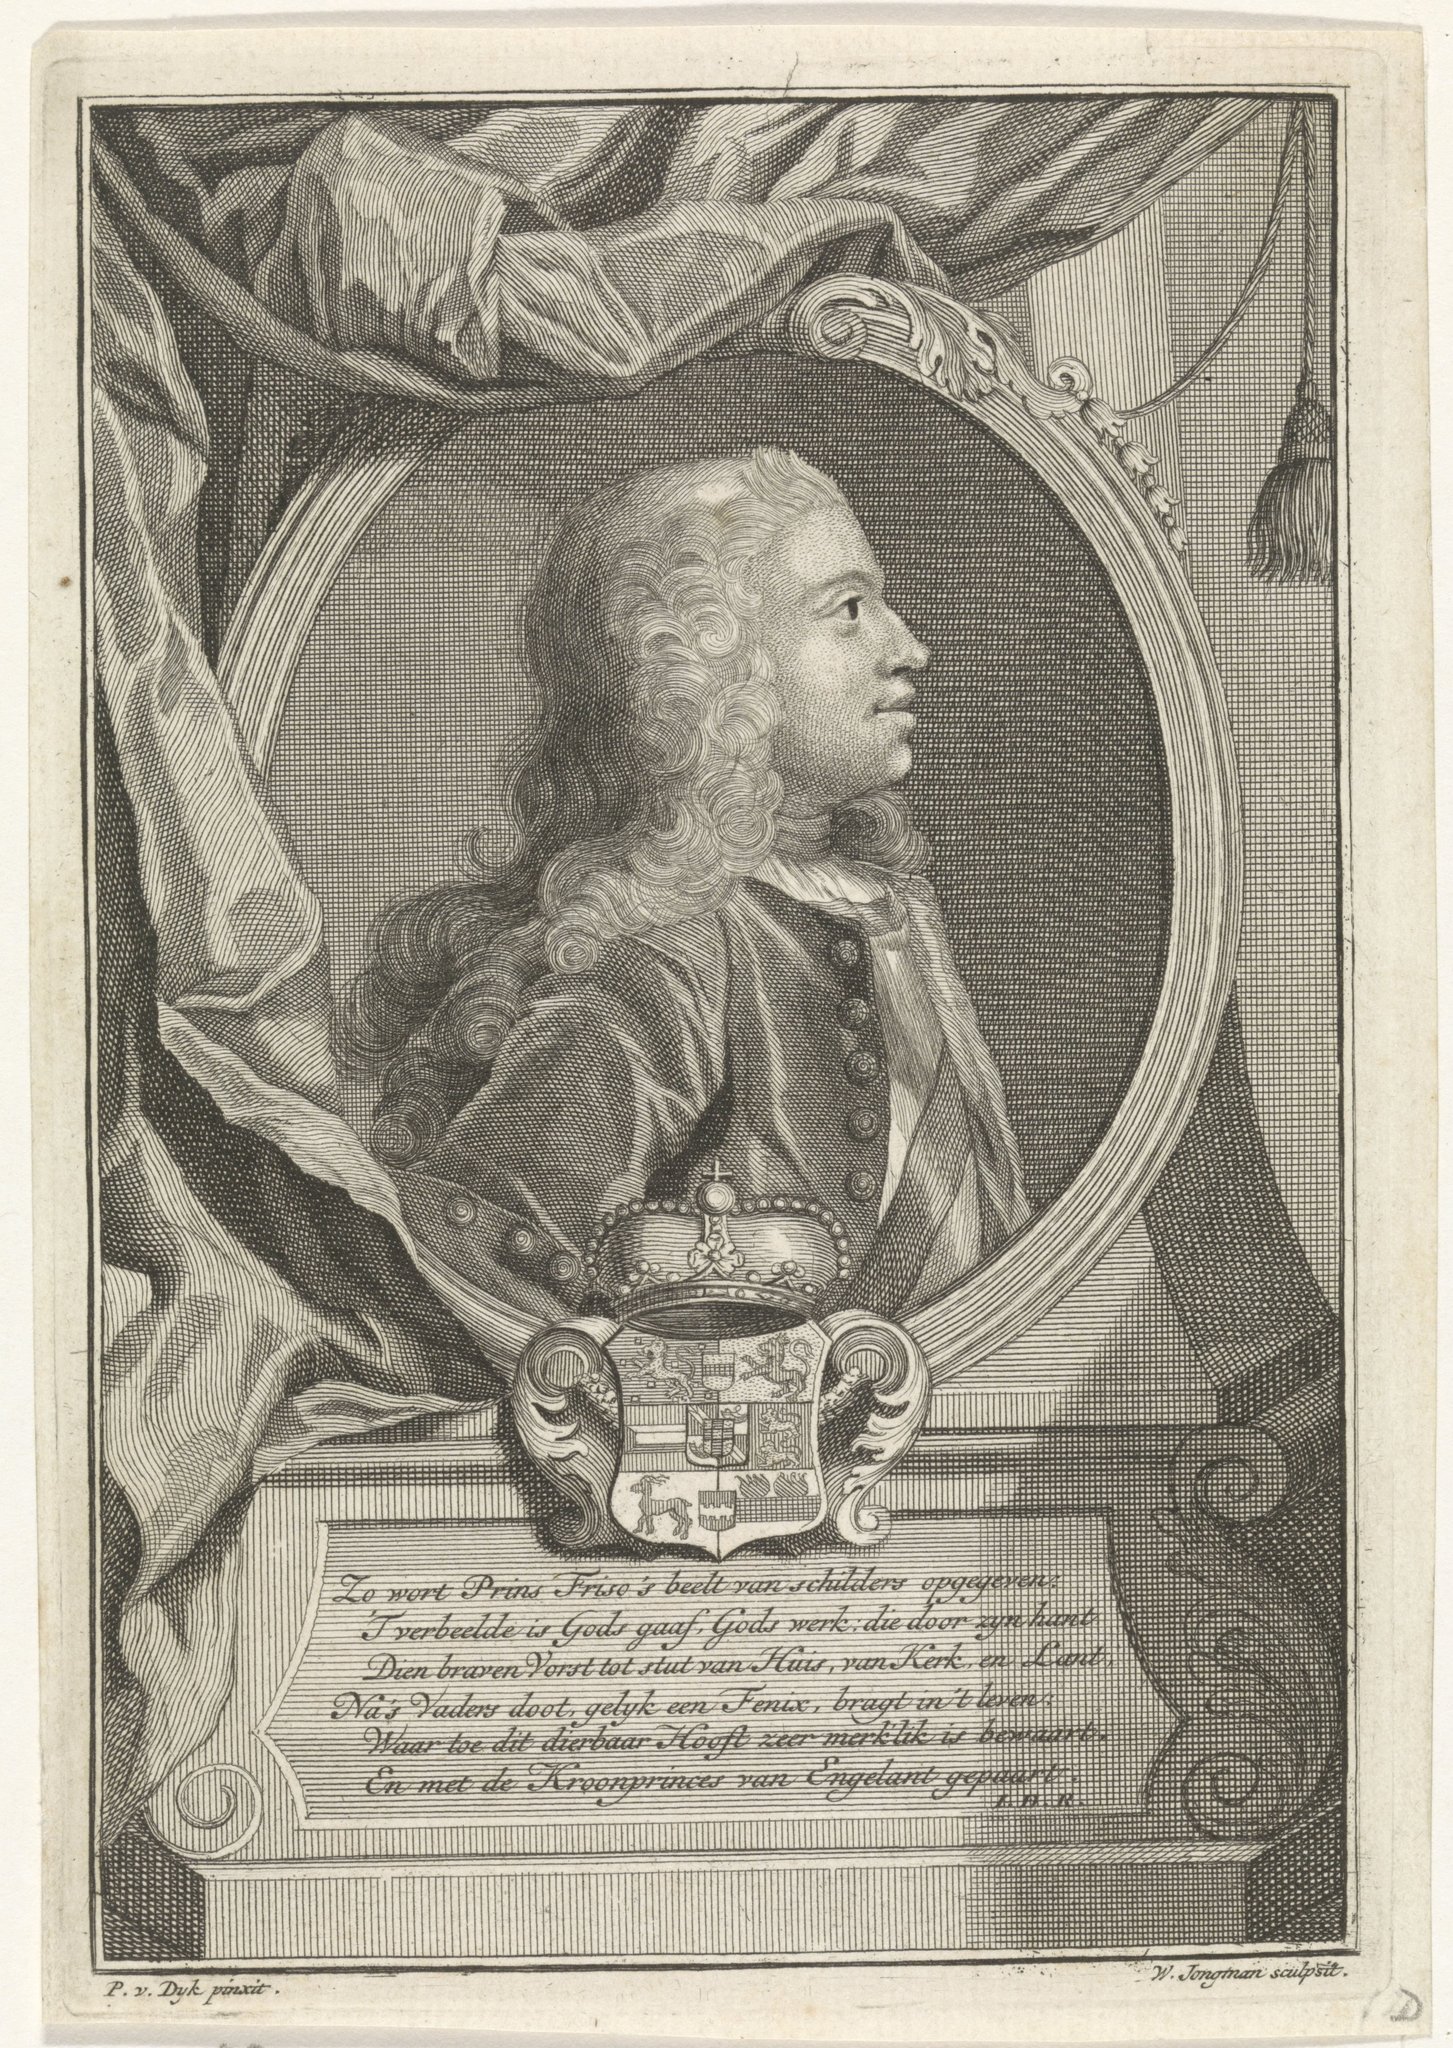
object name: print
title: Portret van Willem IV, prins van Oranje-Nassau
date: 1712-1744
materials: paper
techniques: engraving, etching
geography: amsterdam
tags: the hague, willem iv (prins van oranje-nassau), crown (symbol of sovereignty)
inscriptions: collector's mark: Lugt 2228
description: Busteportret van Willem IV. Het portret is gevat in een ovale omlijsting met bekroond wapenschild van de geportretteerde. In een kader op de piëdestal een zesregelig gedicht in het Nederlands.